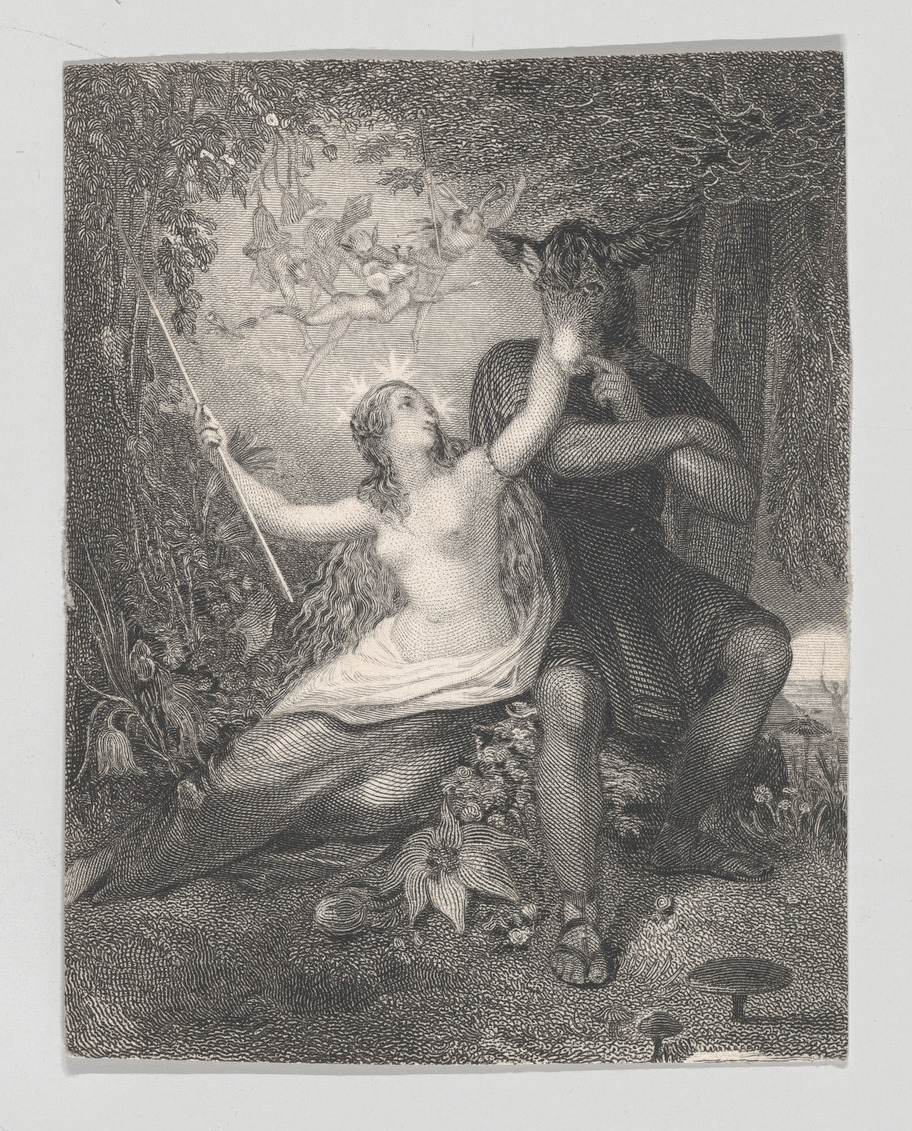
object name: print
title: Titania and Bottom (Shakespeare, Midsummer Night's Dream, Act 3, Scene 1)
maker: charles heath, the elder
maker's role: engraver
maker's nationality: british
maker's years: 1785-1848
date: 1825-1840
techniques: engraving, etching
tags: shakespeare,men,female nudes